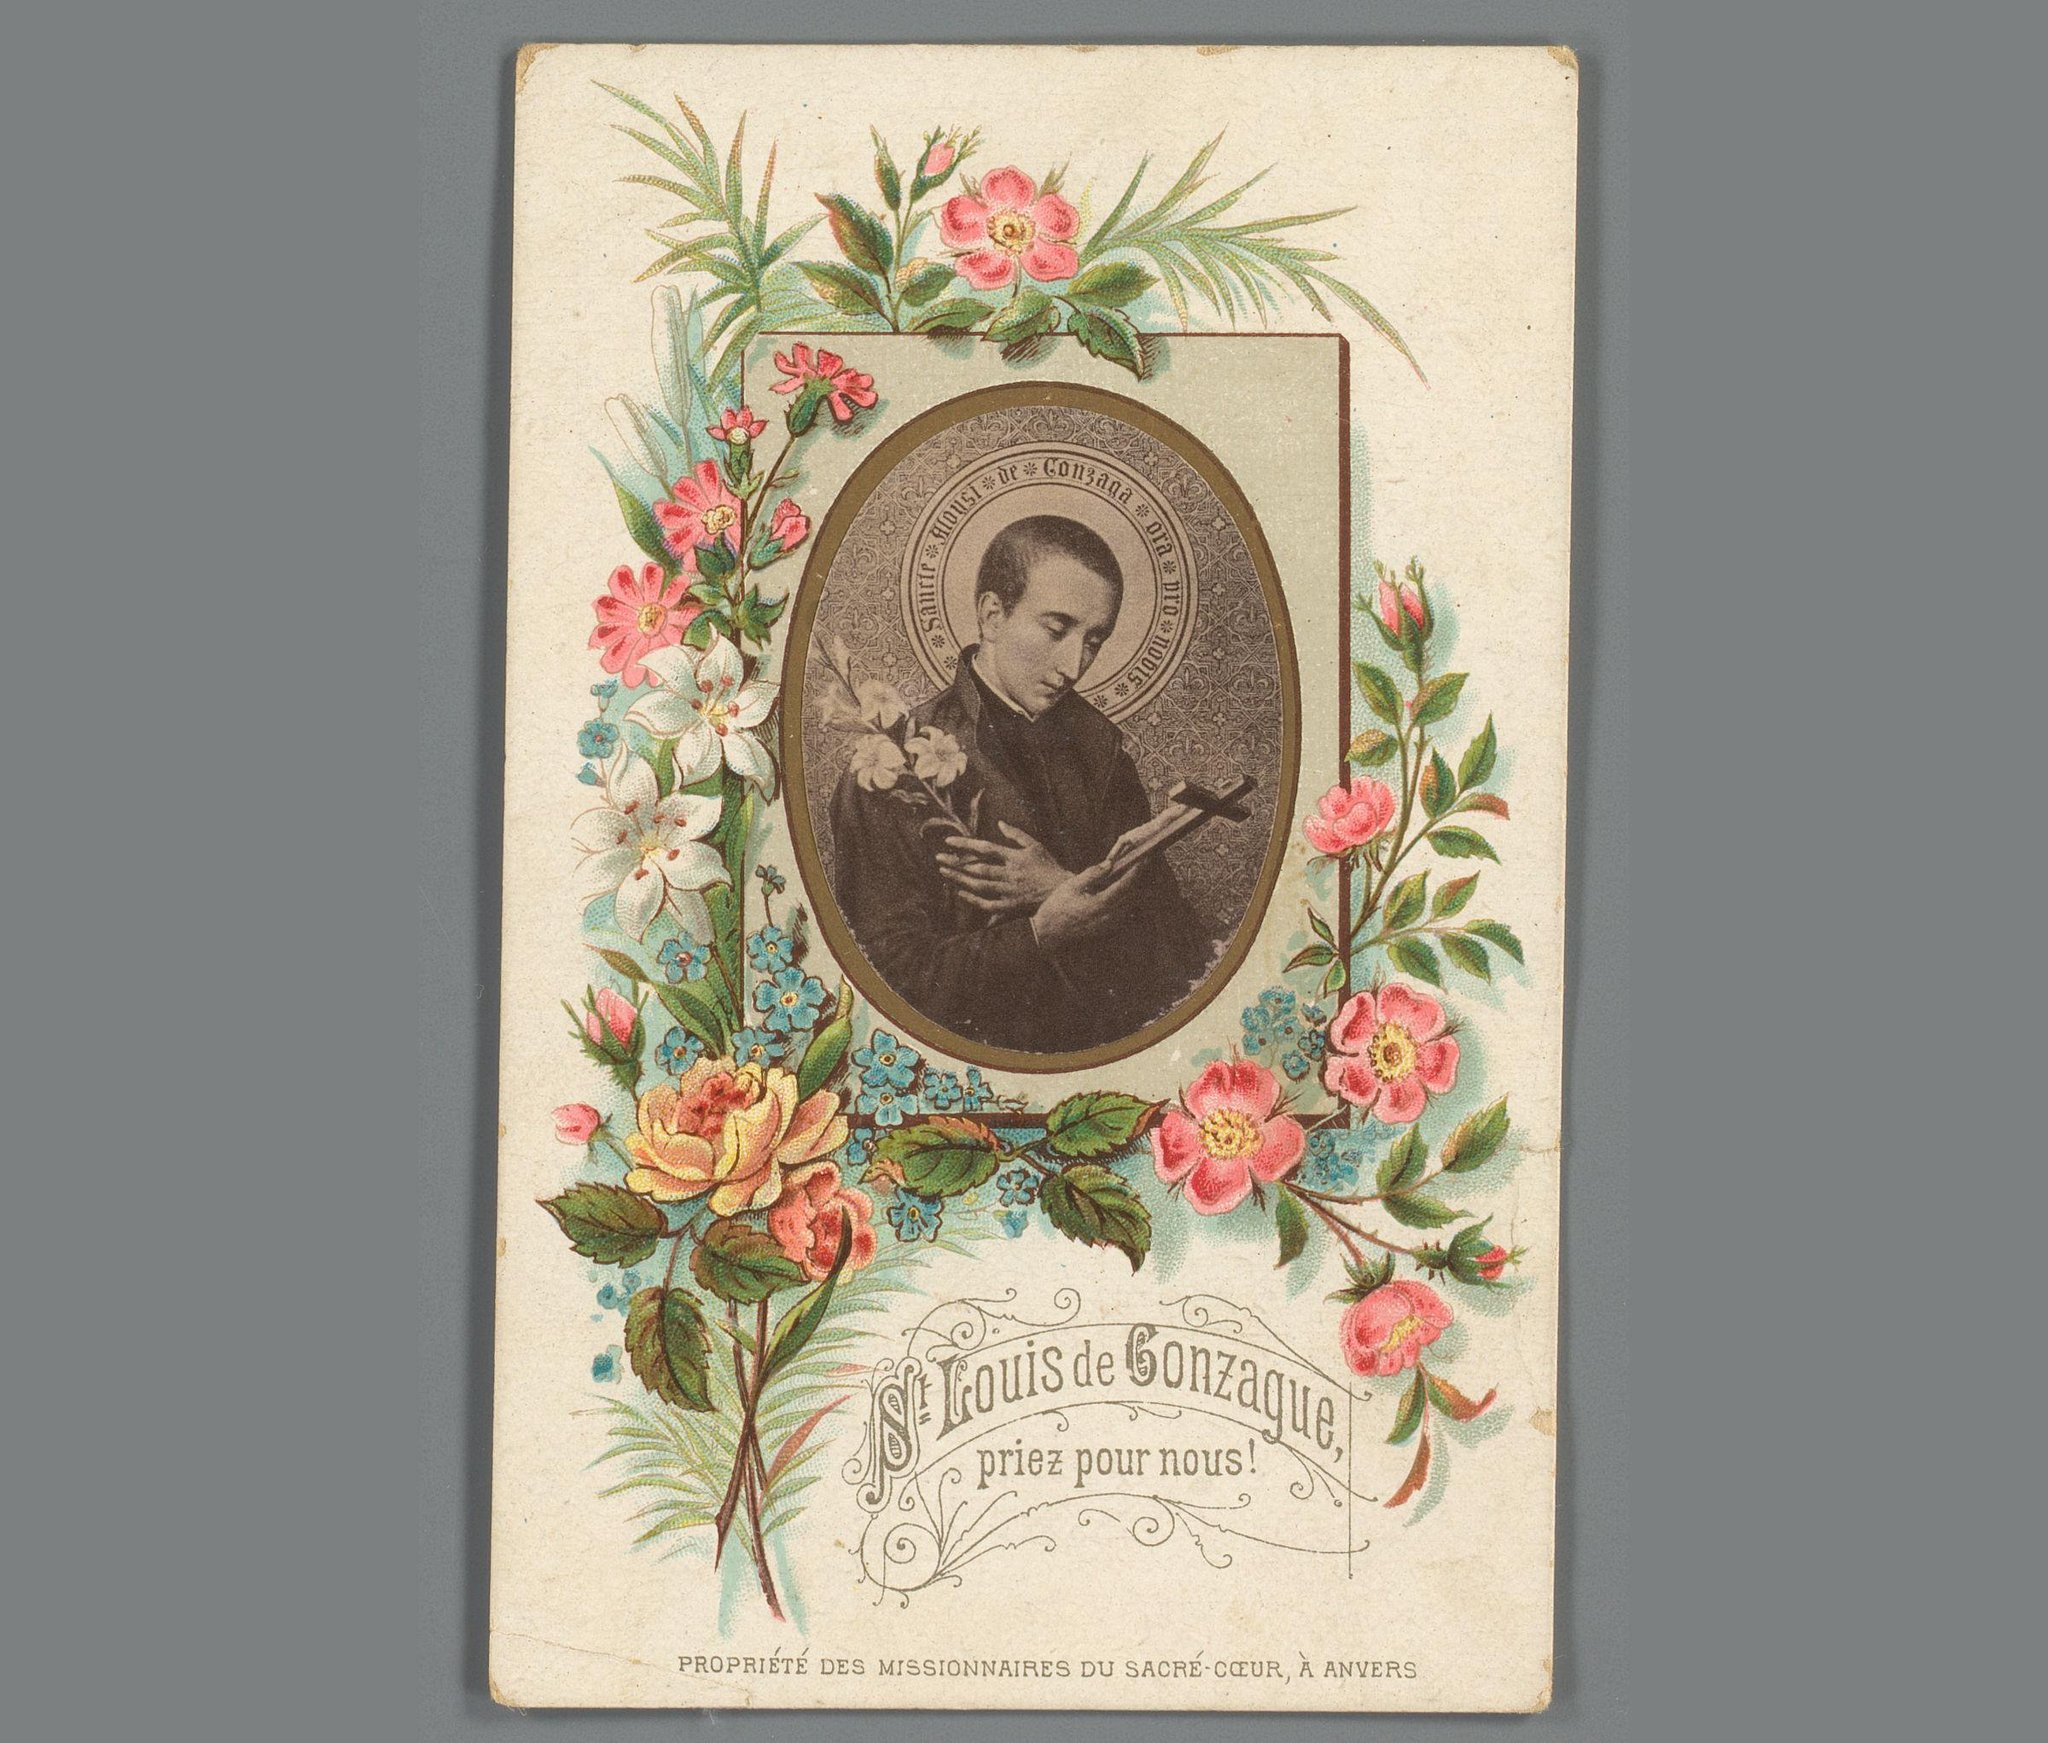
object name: reproduction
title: Reproductie van een schilderij van de heilige Aloysius Gonzaga op bidprent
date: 1875-1880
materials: paper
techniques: chromolithography, photograph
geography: mönchengladbach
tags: picture, painting, devotion: all saints picture, 'allerheiligenbild'